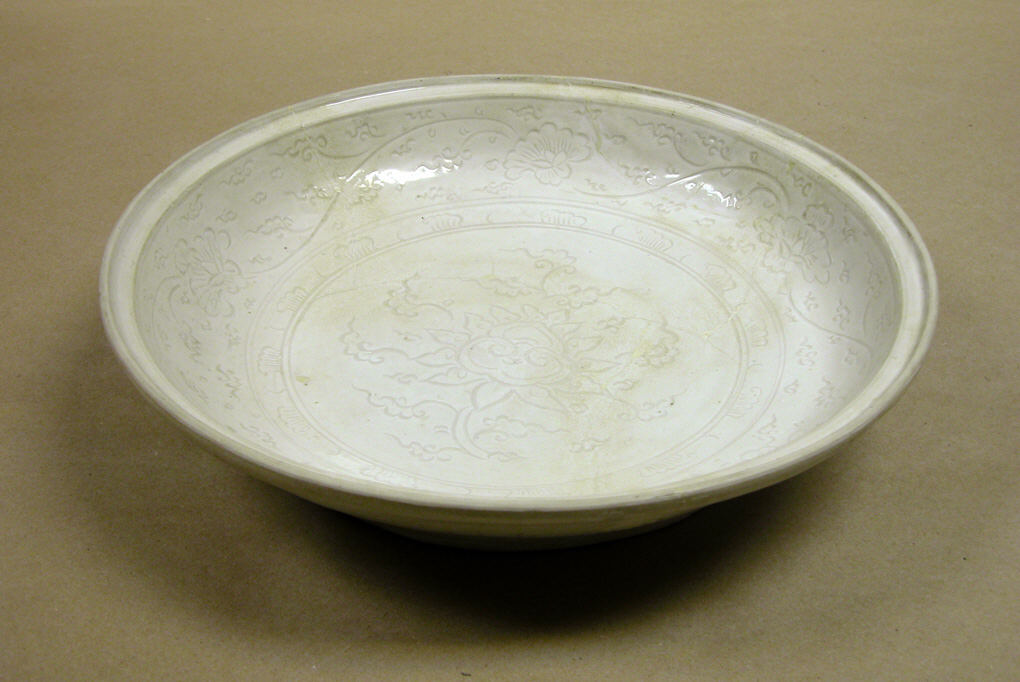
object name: dish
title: Large Incised Dish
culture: vietnamese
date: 1401-1600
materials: glaze, stoneware